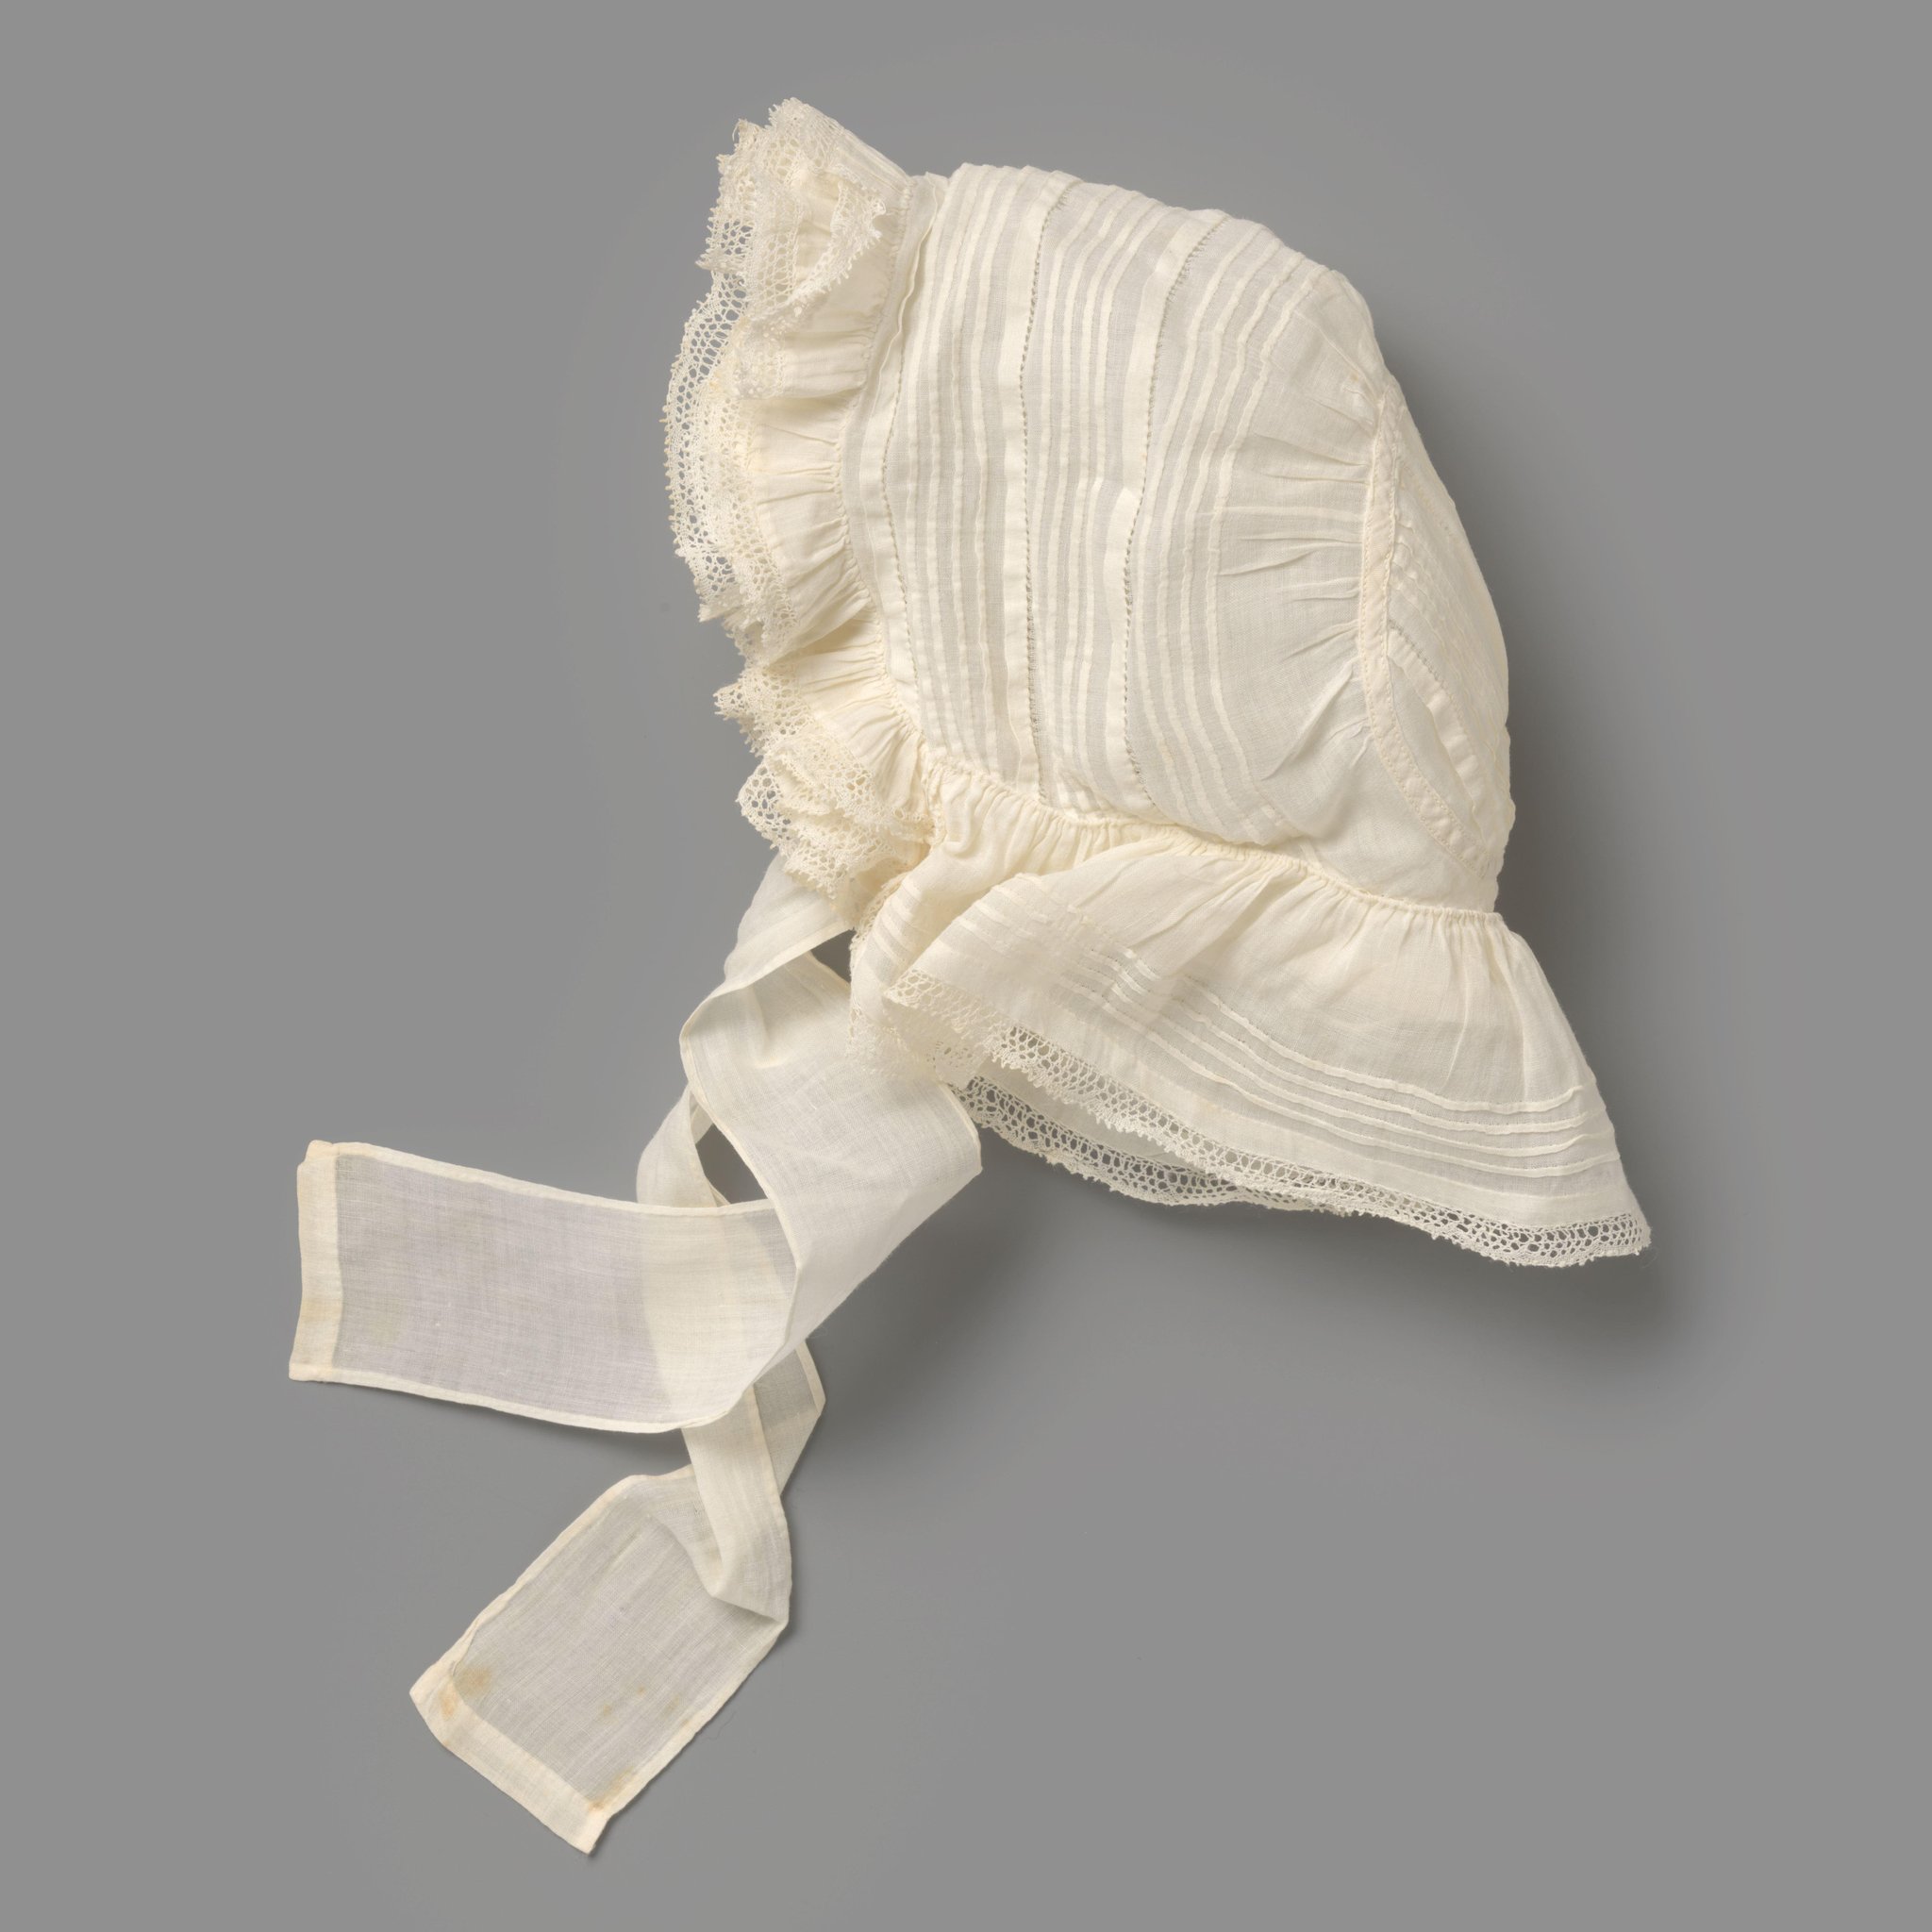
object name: girls' wear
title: Meisjesmuts van dunne witte katoen, geheel versierd met oprijgen, met brede striklinten van de stof; voorop drie ruches met kantrand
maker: Anonymous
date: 1890-1909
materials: textile, cotton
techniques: lace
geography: netherlands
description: Baby mutsjes van linnen, batist en genopt neteldoek met hefijzervormige of ronde bol(voor meisjes), versierd met strookjes kloskant. Patroon: Het batist heeft machinegenaaide oprijgjes van afwisselend èèn brede en drie smalle. Een drie dubbele voorstrook en èèn brede achterstrook zijn met smal kloskant afgewerkt. Brede aangenaaide kinnebanden van batist. Toestand. In 1979 gewassen.